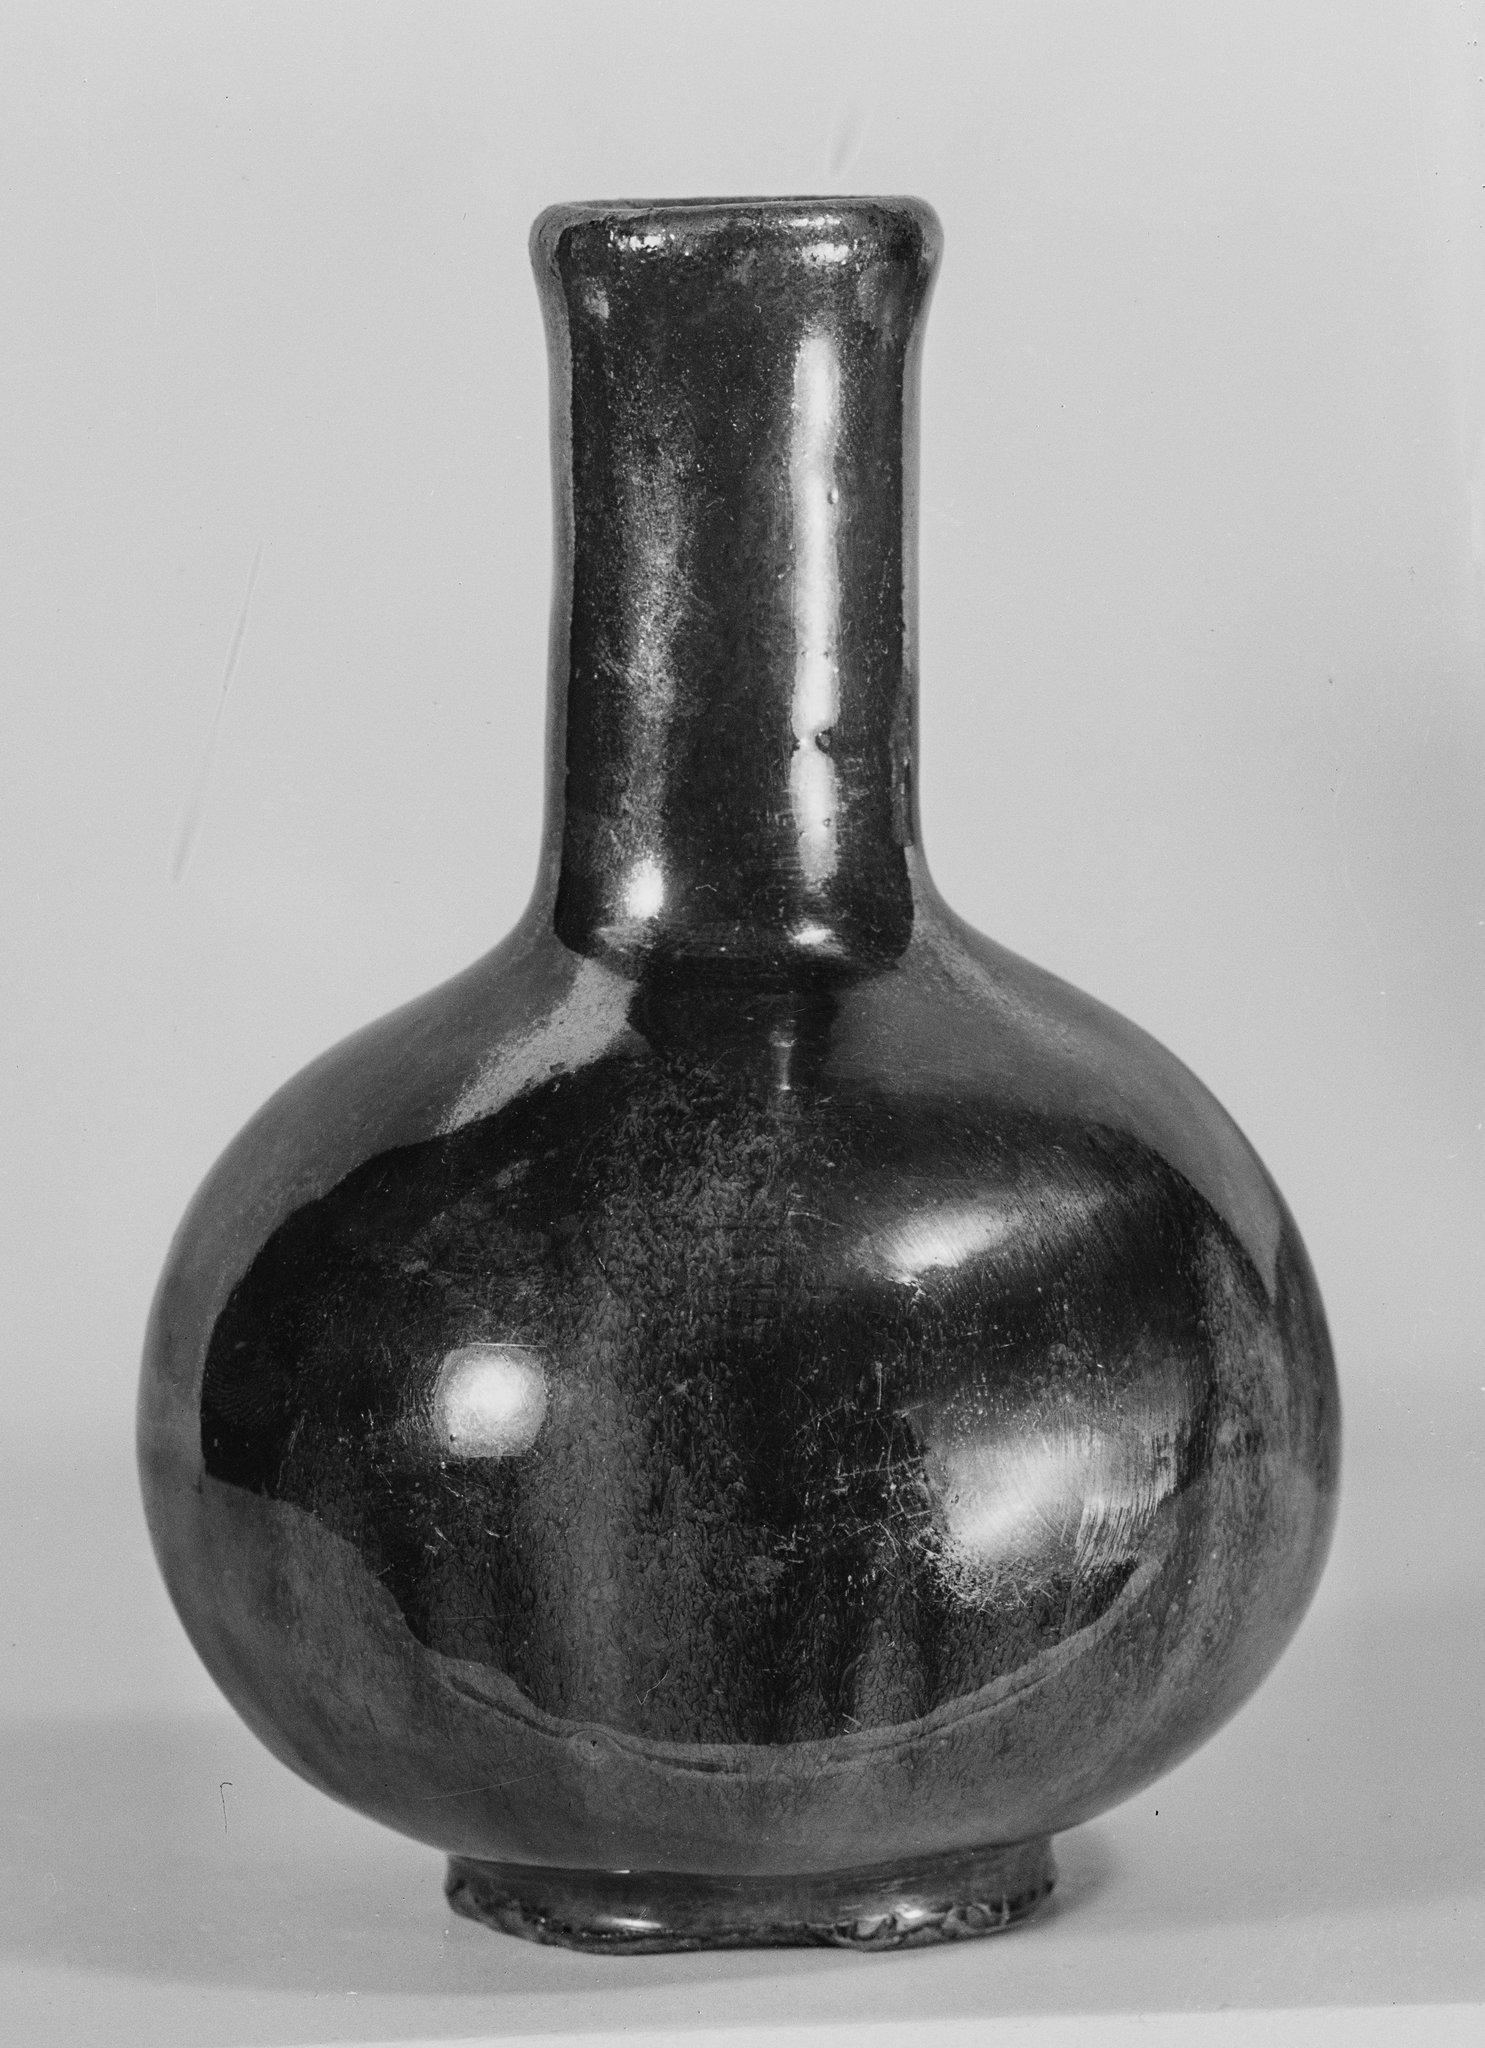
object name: bottle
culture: japanese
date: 1801-1900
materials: clay, glaze